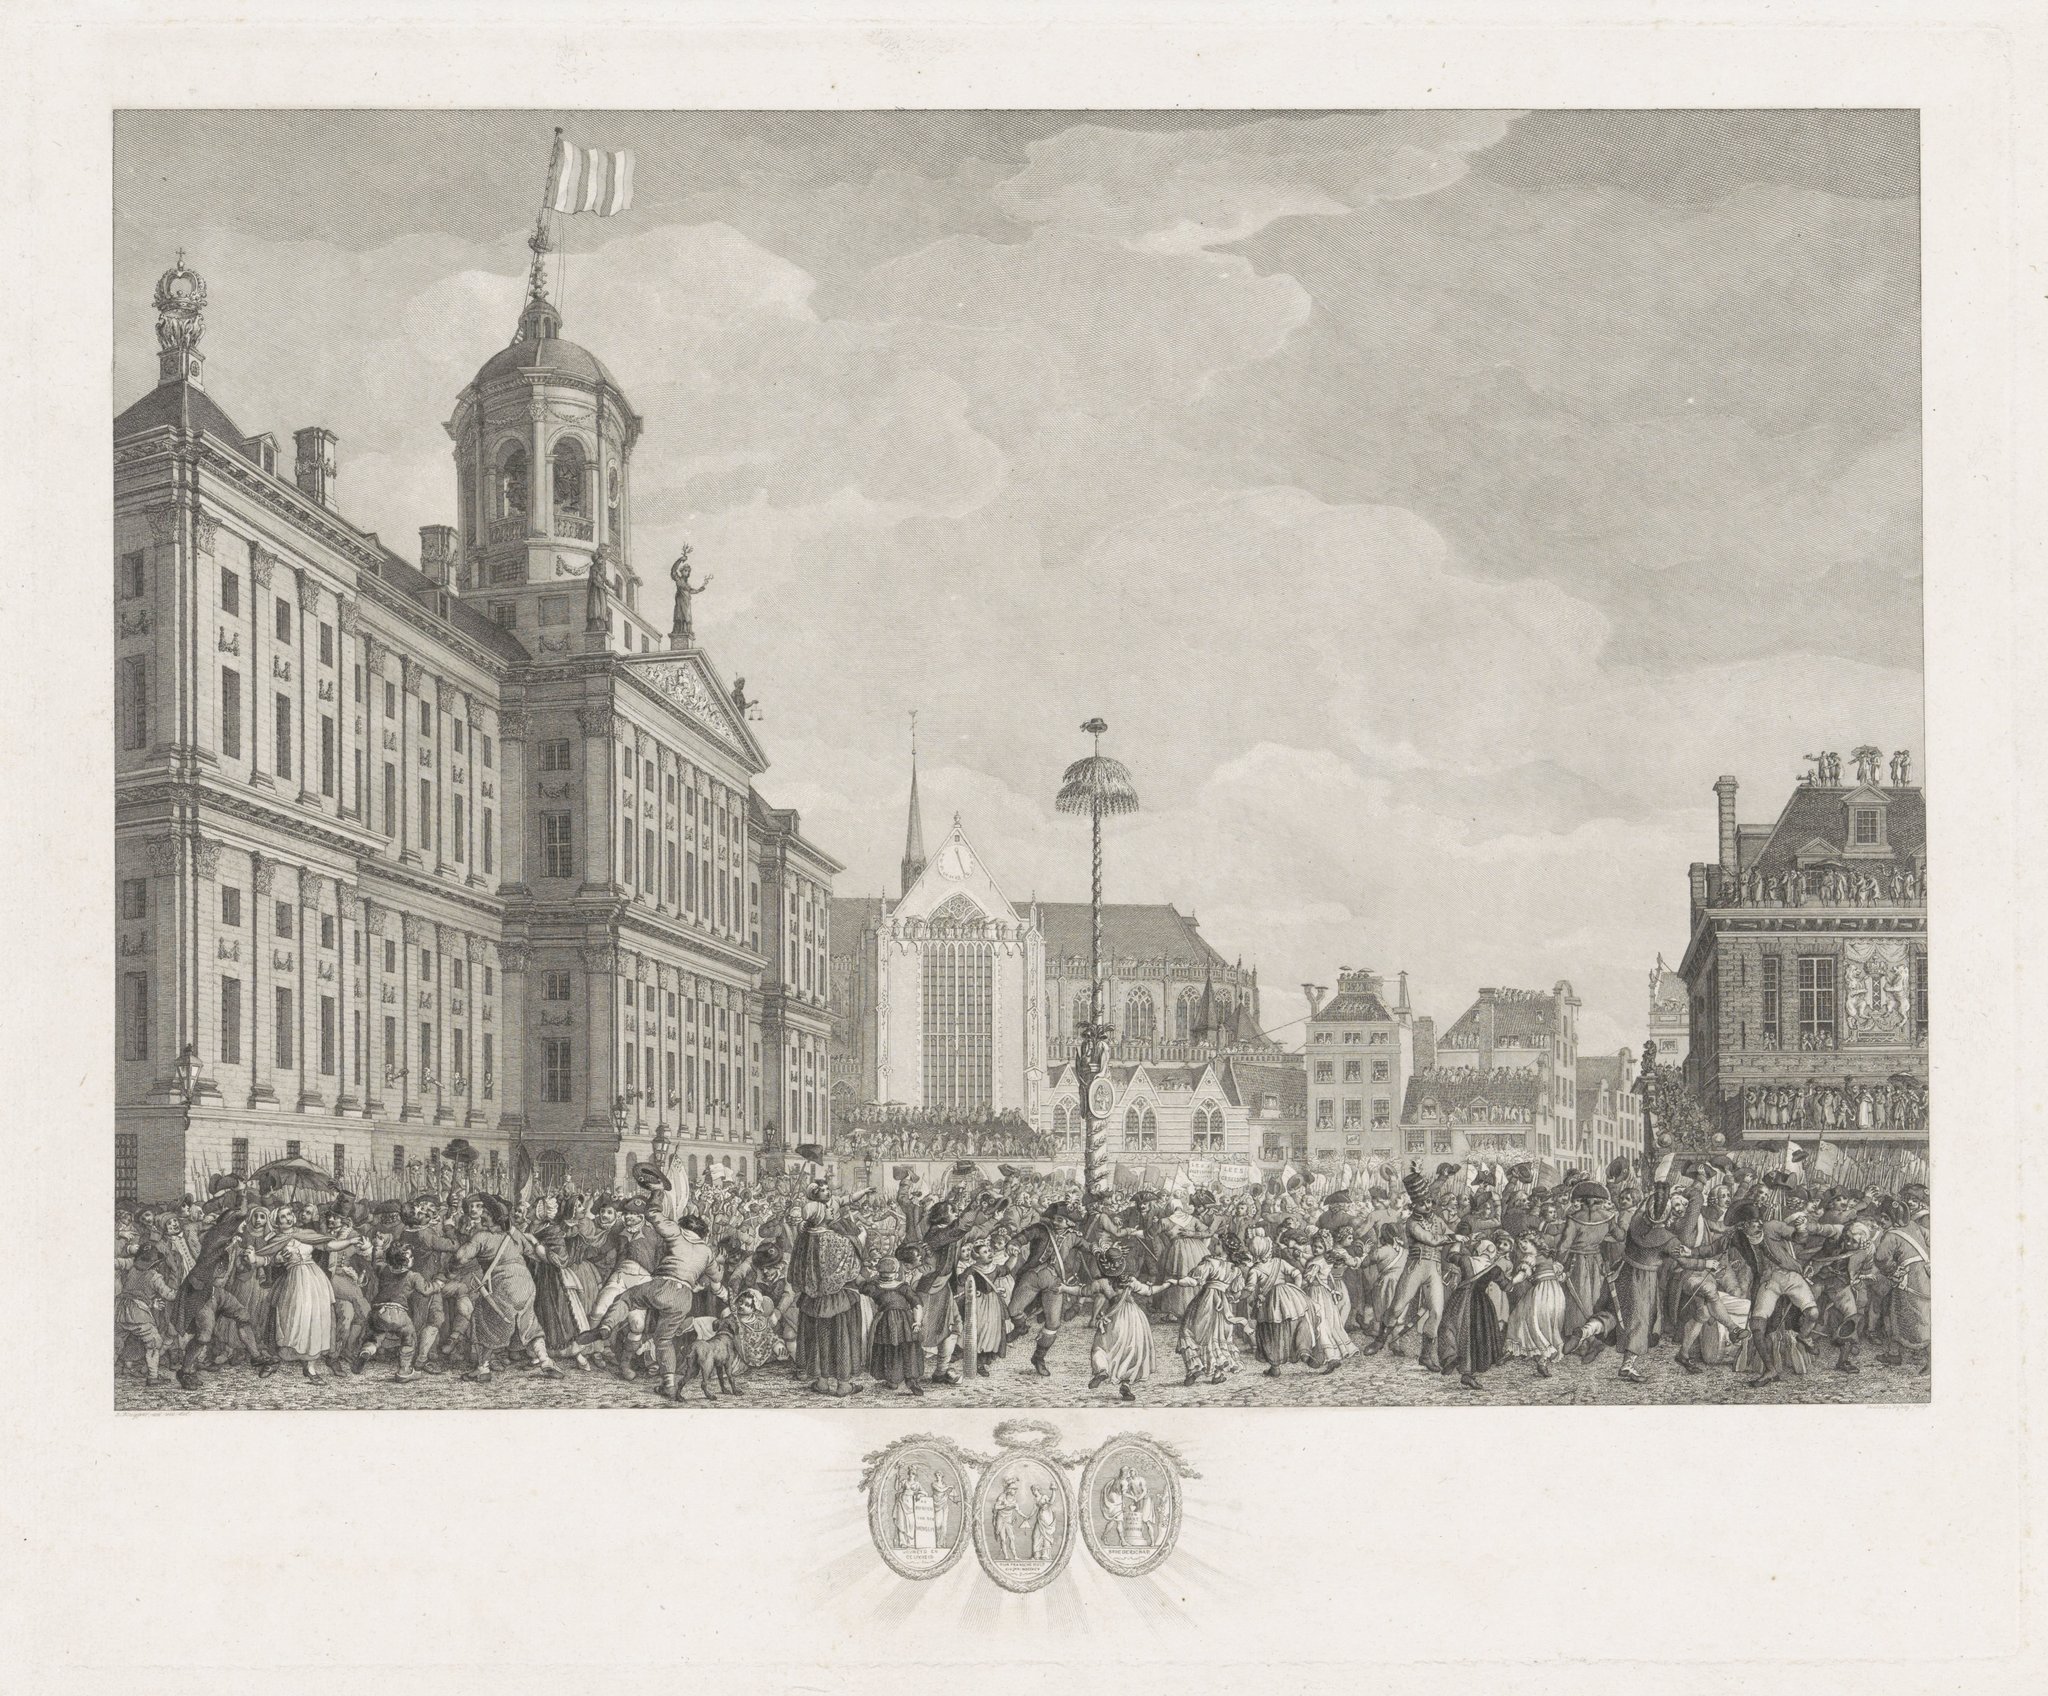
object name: print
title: Feest der Vrijheid op de Dam te Amsterdam, 4 maart 1795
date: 1795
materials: paper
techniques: engraving, etching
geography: amsterdam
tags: dancing around the tree of liberty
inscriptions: collector's mark: Lugt 2228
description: Feest der Vrijheid, gevierd bij de inwijding van de vrijheidsboom op de Dam te Amsterdam, 4 maart 1795. Gezicht op de Dam met een grote menigte dansend om de vrijheidsboom. In de marge de drie allegorische emblemen van Vrijheid, Gelijkheid en Broederschap die aan de boom hingen.